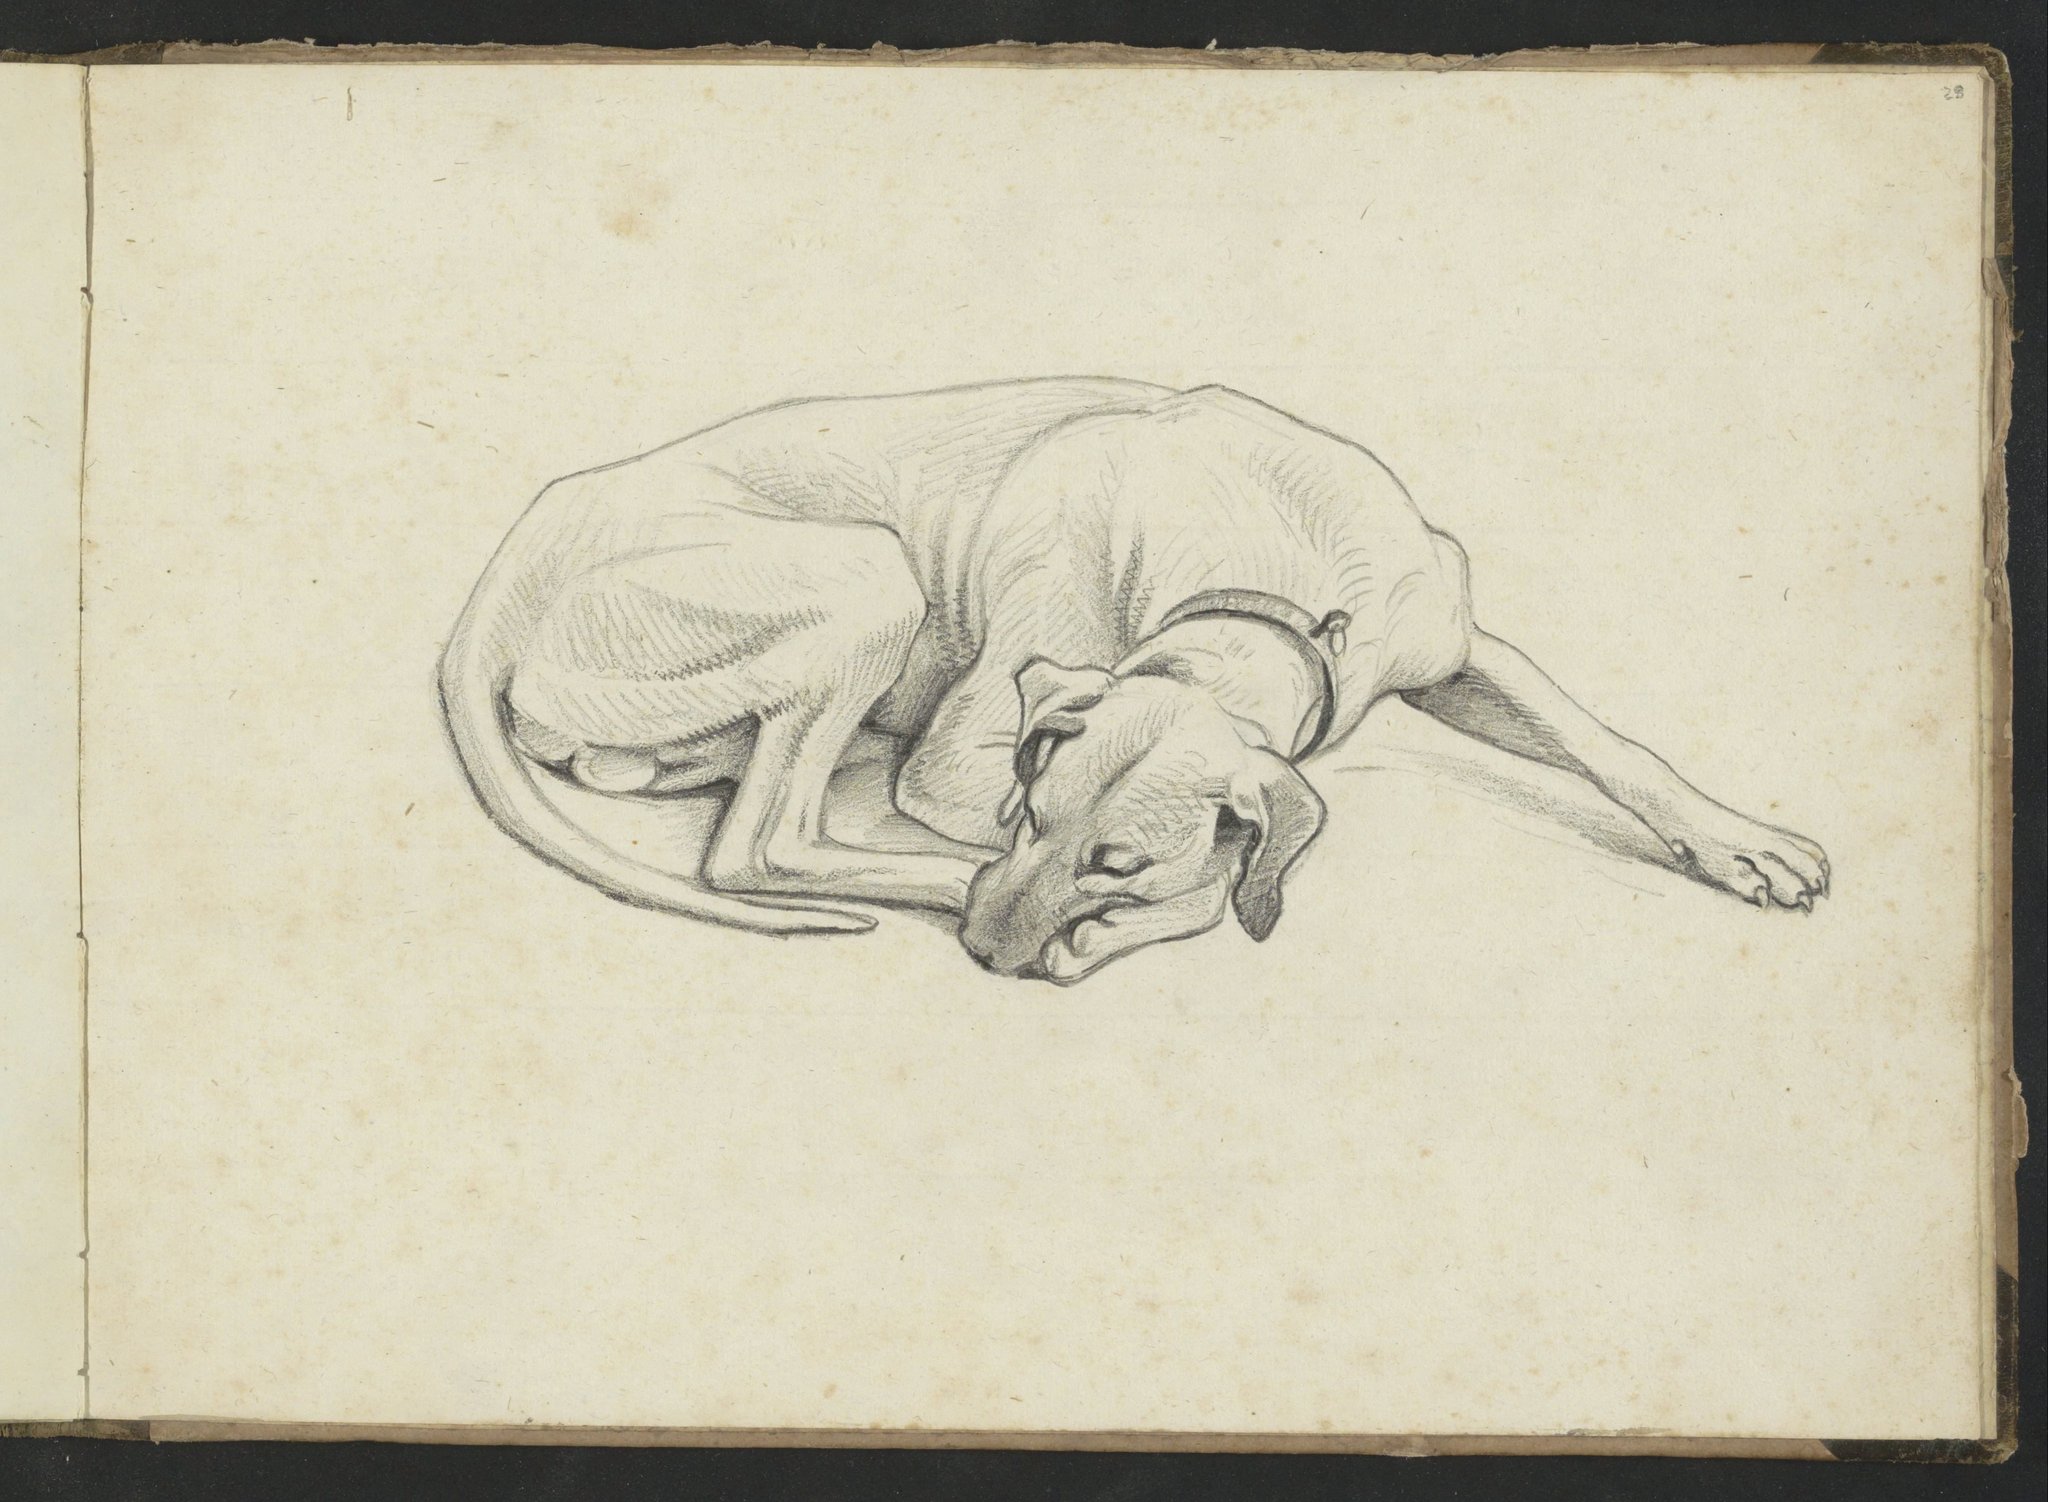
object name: sketchbook leaf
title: Slapende hond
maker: abraham teerlink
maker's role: draughtsman, painter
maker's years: 1776-1857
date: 1808-1857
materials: paper, pencil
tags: dog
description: Blad 28 recto uit een schetsboek met 28 bladen.